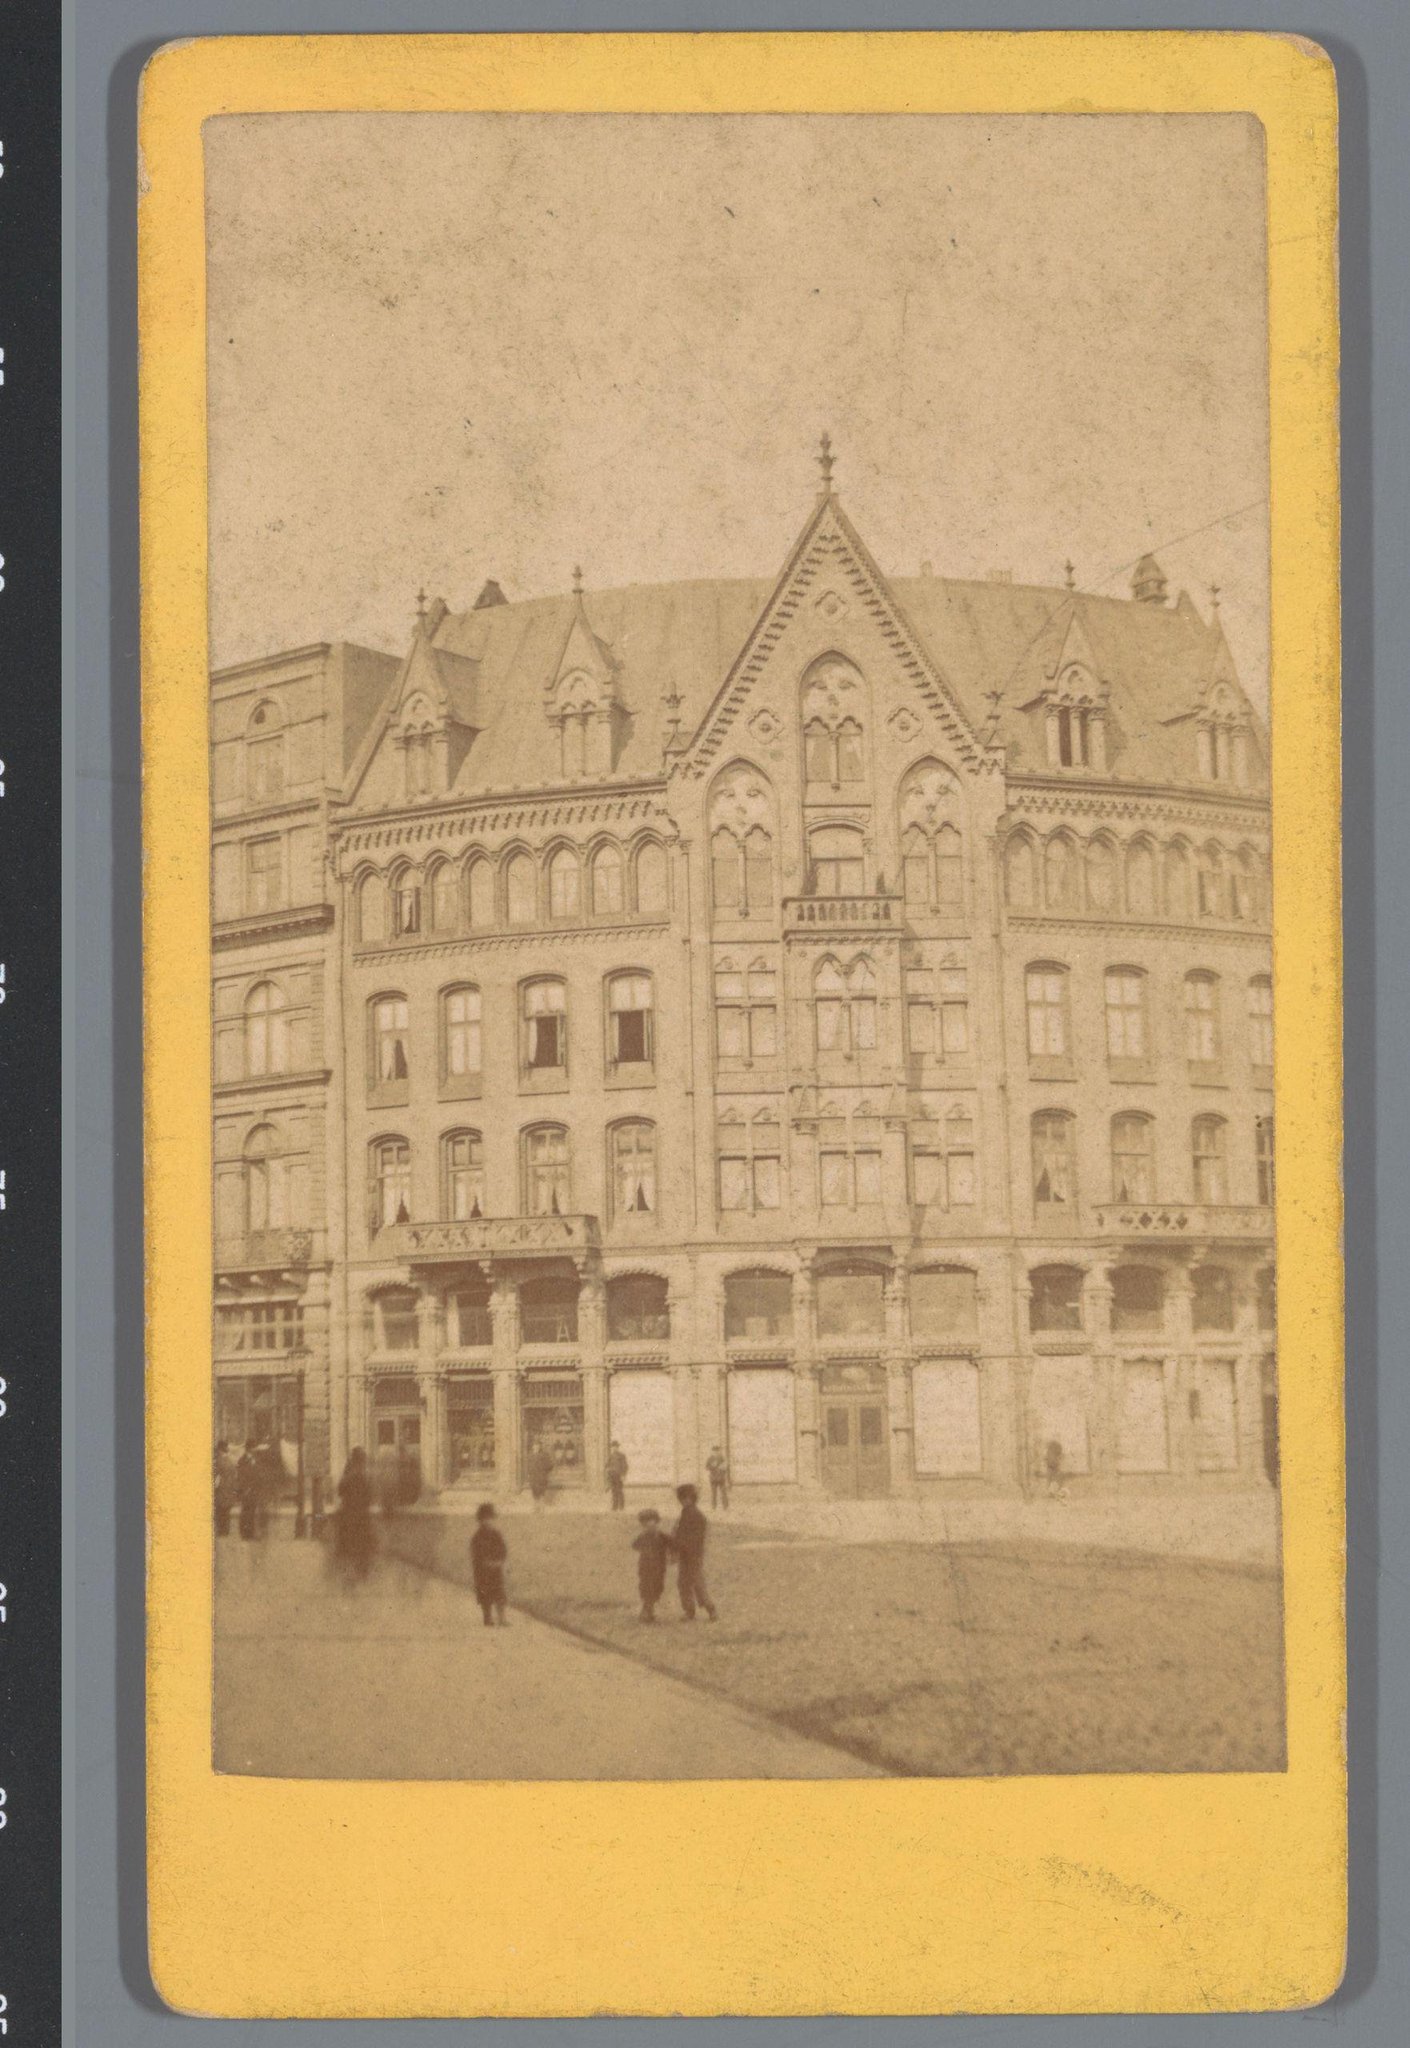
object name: photograph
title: Straat in een stad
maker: Anonymous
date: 1854-1885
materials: cardboard, paper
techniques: albumen print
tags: street